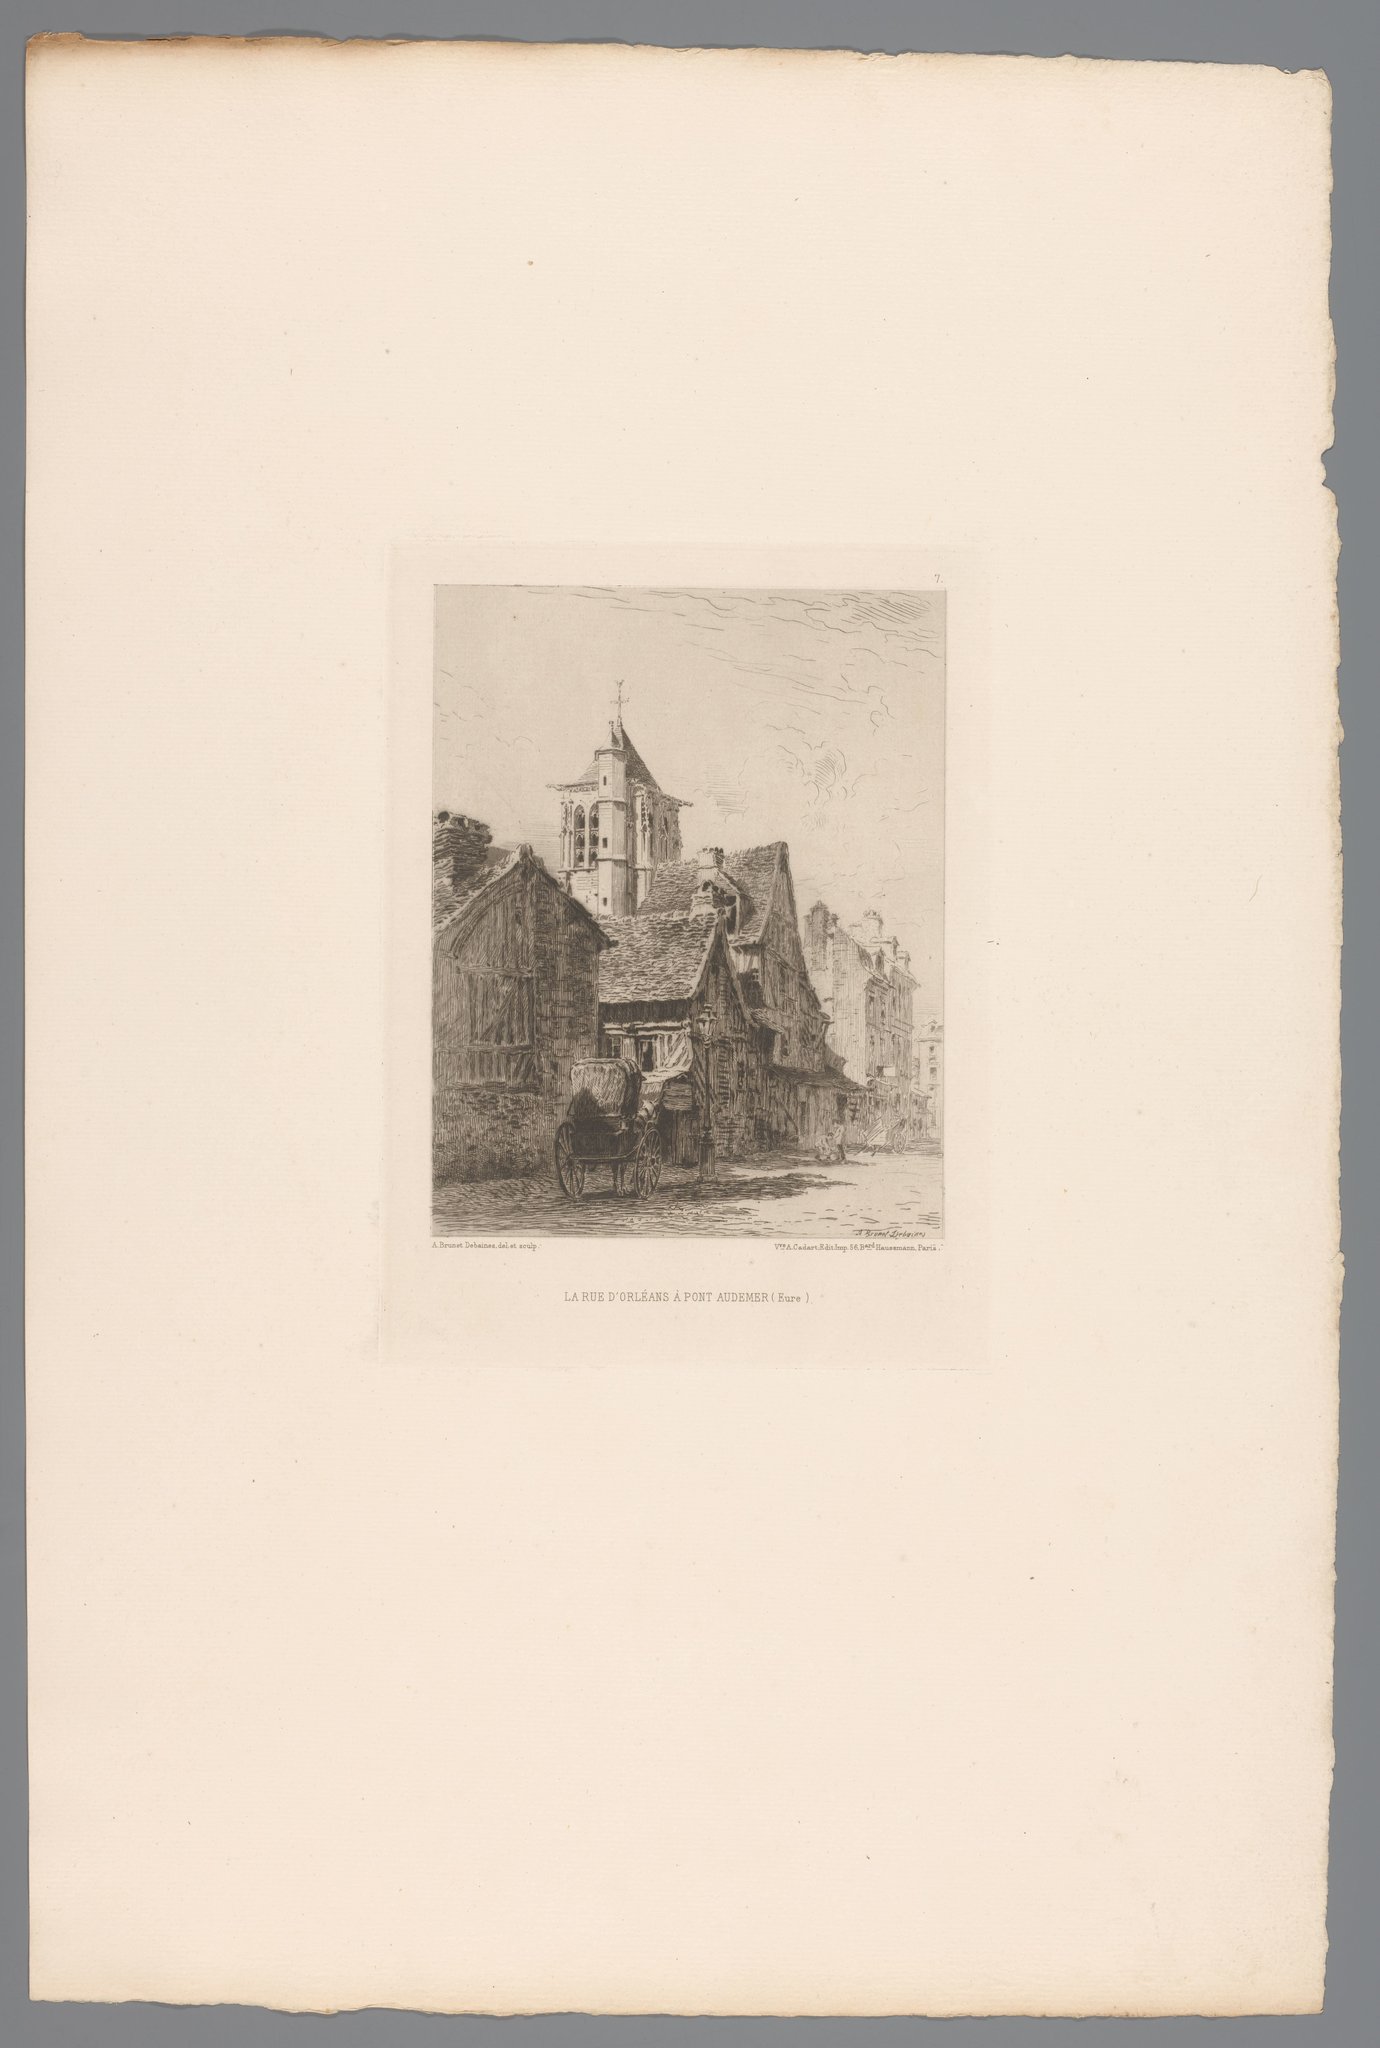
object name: print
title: La Rue d'Orléans à Pont Audemer, Eure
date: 1877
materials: paper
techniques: drypoint, etching, intaglio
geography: paris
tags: street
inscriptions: collector's mark: ‘AFE v S’, collector's mark: Lugt 2760, collector's mark: Lugt 2228